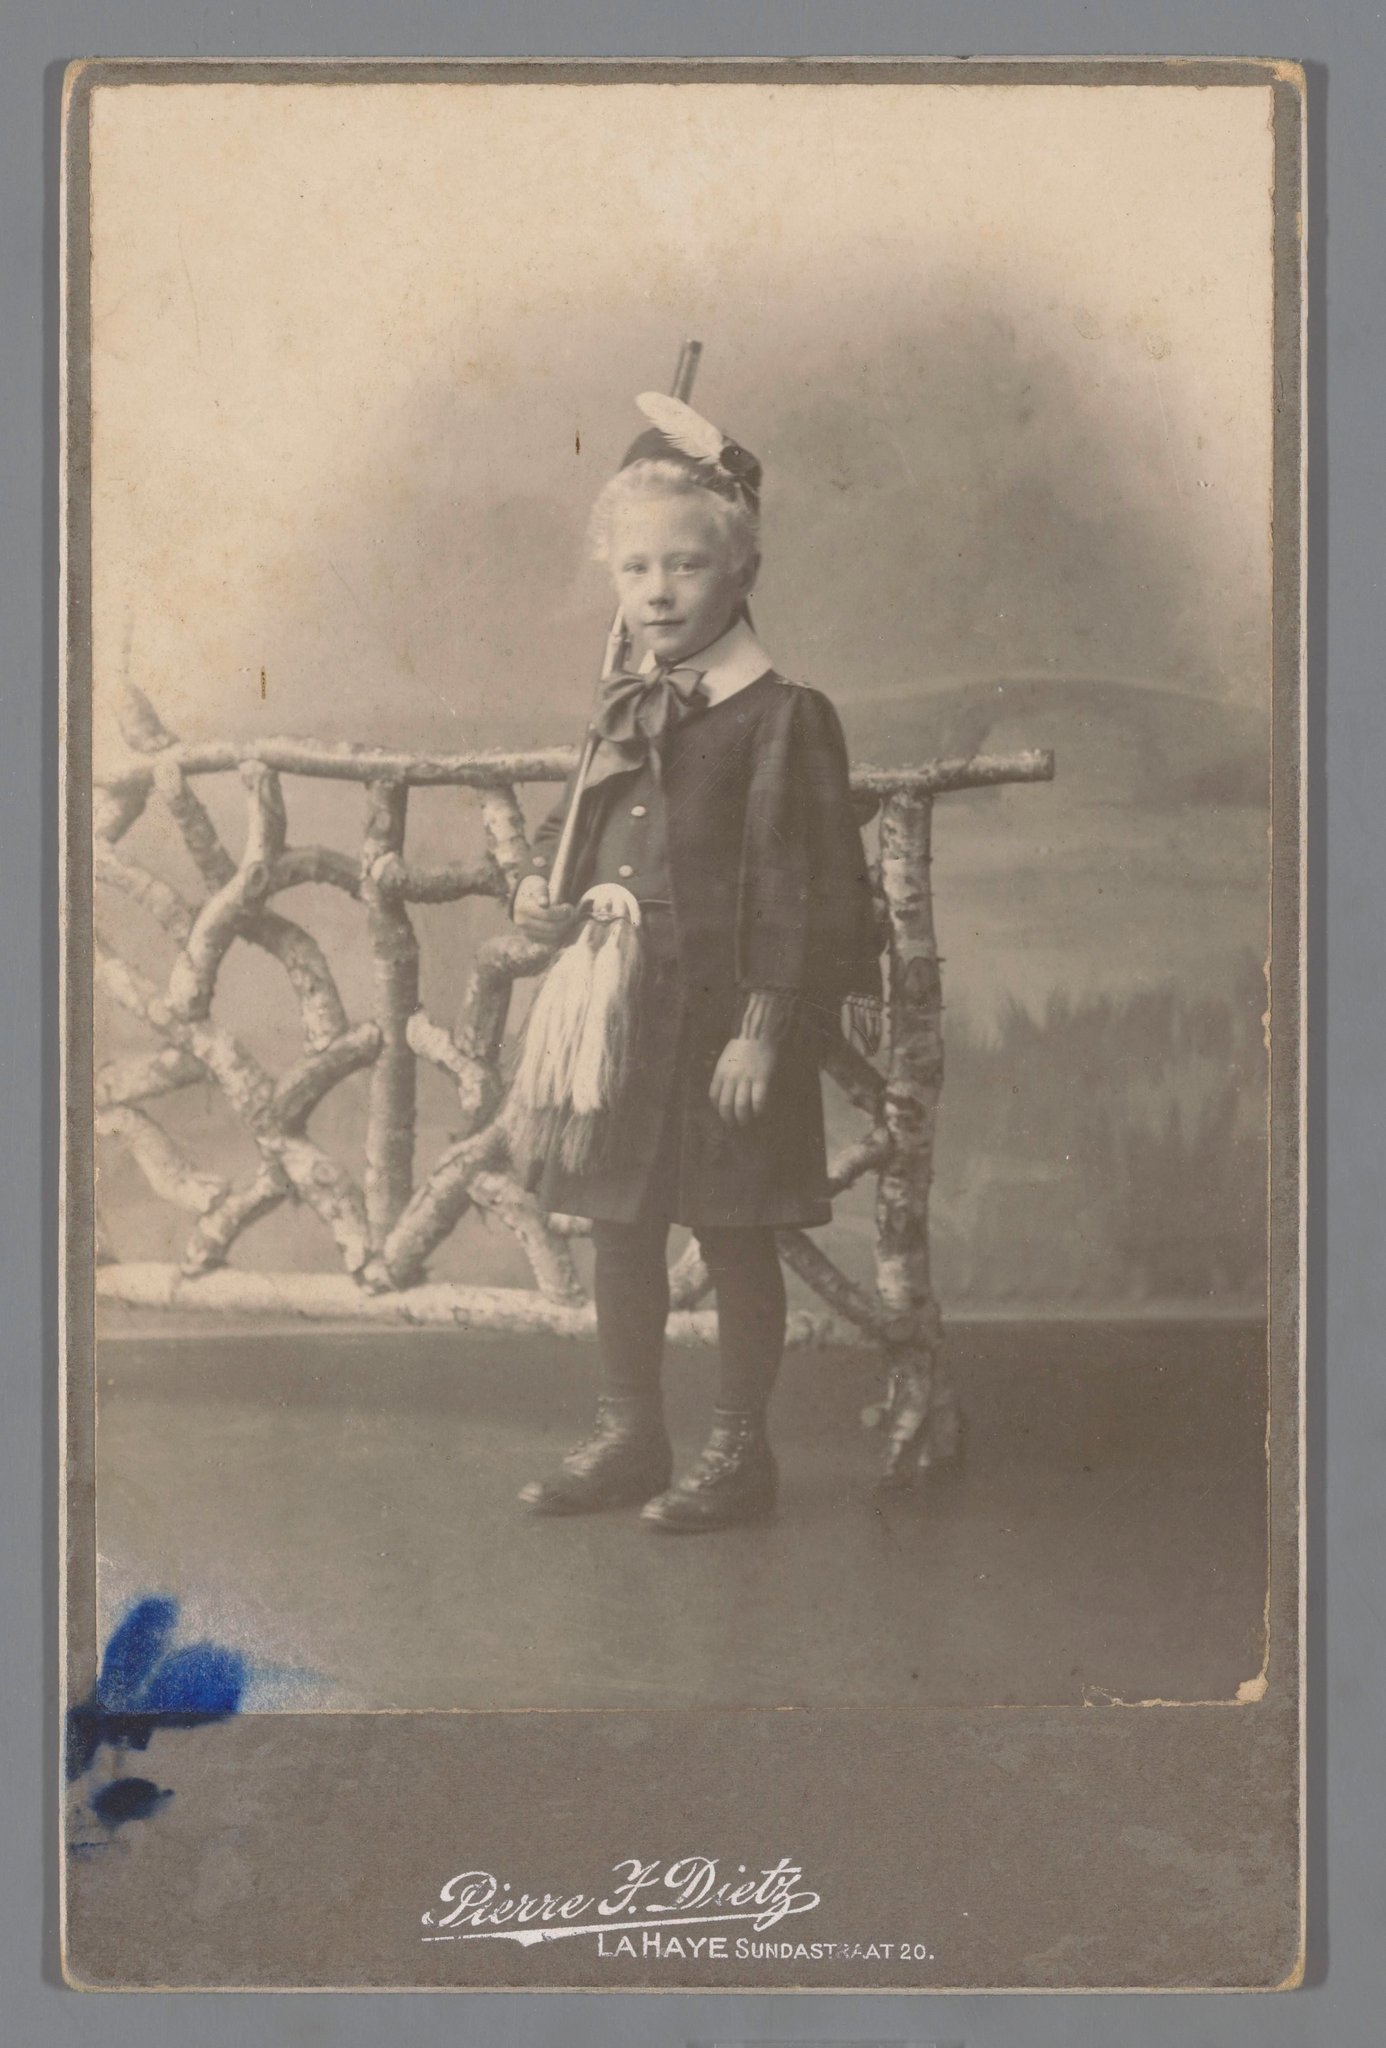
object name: cabinet photograph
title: Portret van een onbekende jongen in een kostuum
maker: pierre j. dietz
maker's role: fotograaf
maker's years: 1879-1959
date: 1906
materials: cardboard, photographic support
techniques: gelatin silver print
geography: the hague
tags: boy (child between toddler and youth), fantasy costume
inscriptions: inscription: ‘Aan zijn Grootmoeder ter herinnering aan zijn 6den Verjaardag op 26 October 1906.’